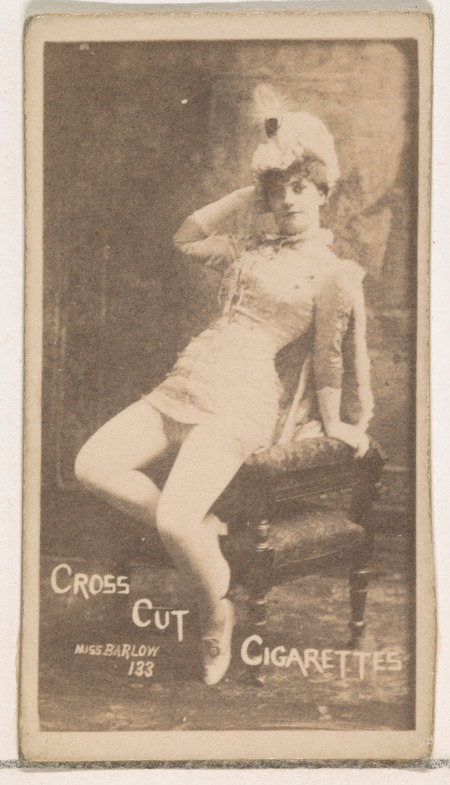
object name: print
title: Card Number 133, Miss Barlow, from the Actors and Actresses series (N145-1) issued by Duke Sons & Co. to promote Cross Cut Cigarettes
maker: w. duke, sons & co.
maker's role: publisher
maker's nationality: american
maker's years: 1870-1920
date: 1880-1889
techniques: albumen silver print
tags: portraits,women,actresses